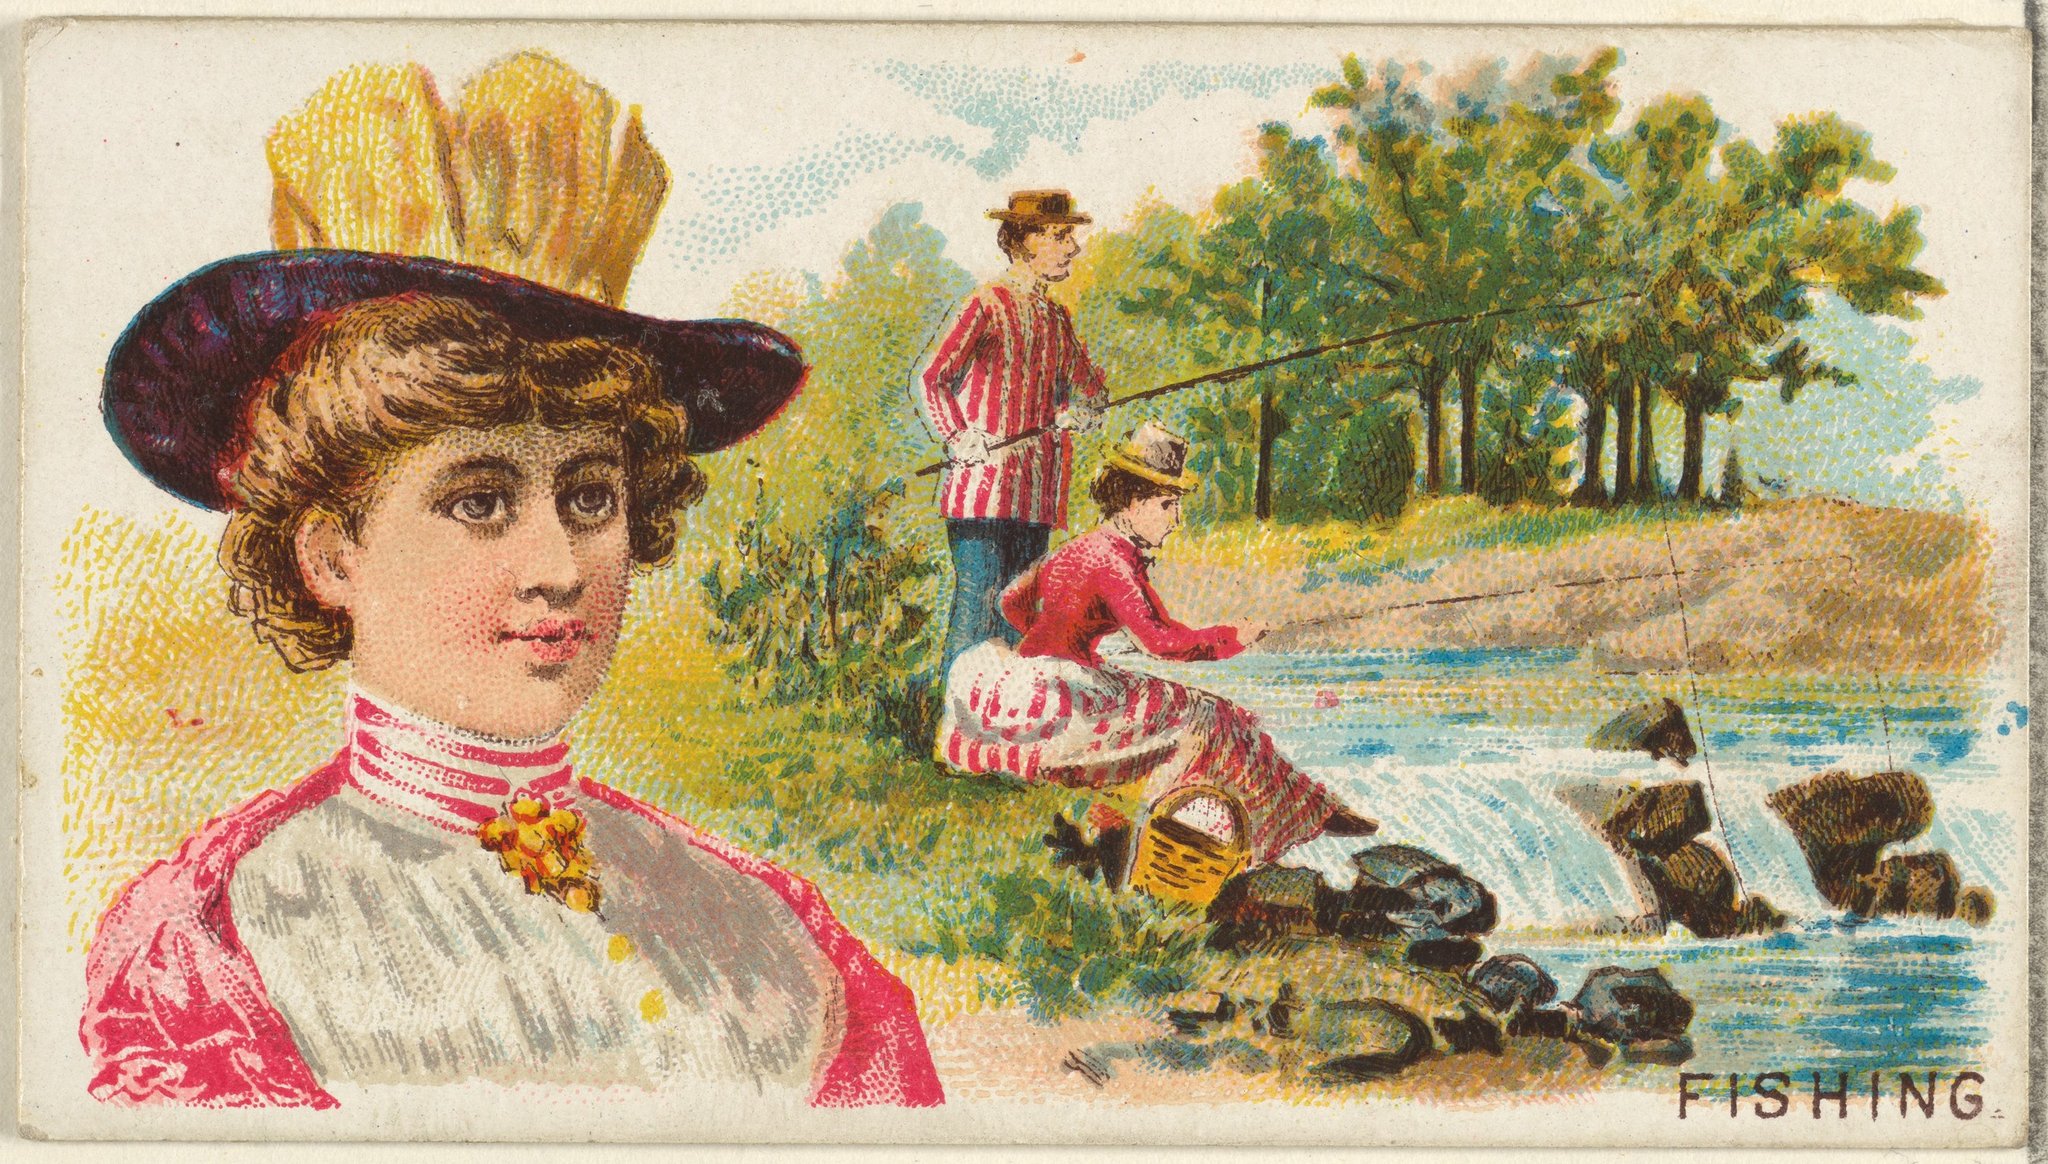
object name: print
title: Fishing, from the Games and Sports series (N165) for Old Judge Cigarettes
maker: goodwin & company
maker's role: publisher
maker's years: 1850-1950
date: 1889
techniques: color lithograph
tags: men,women,fishing